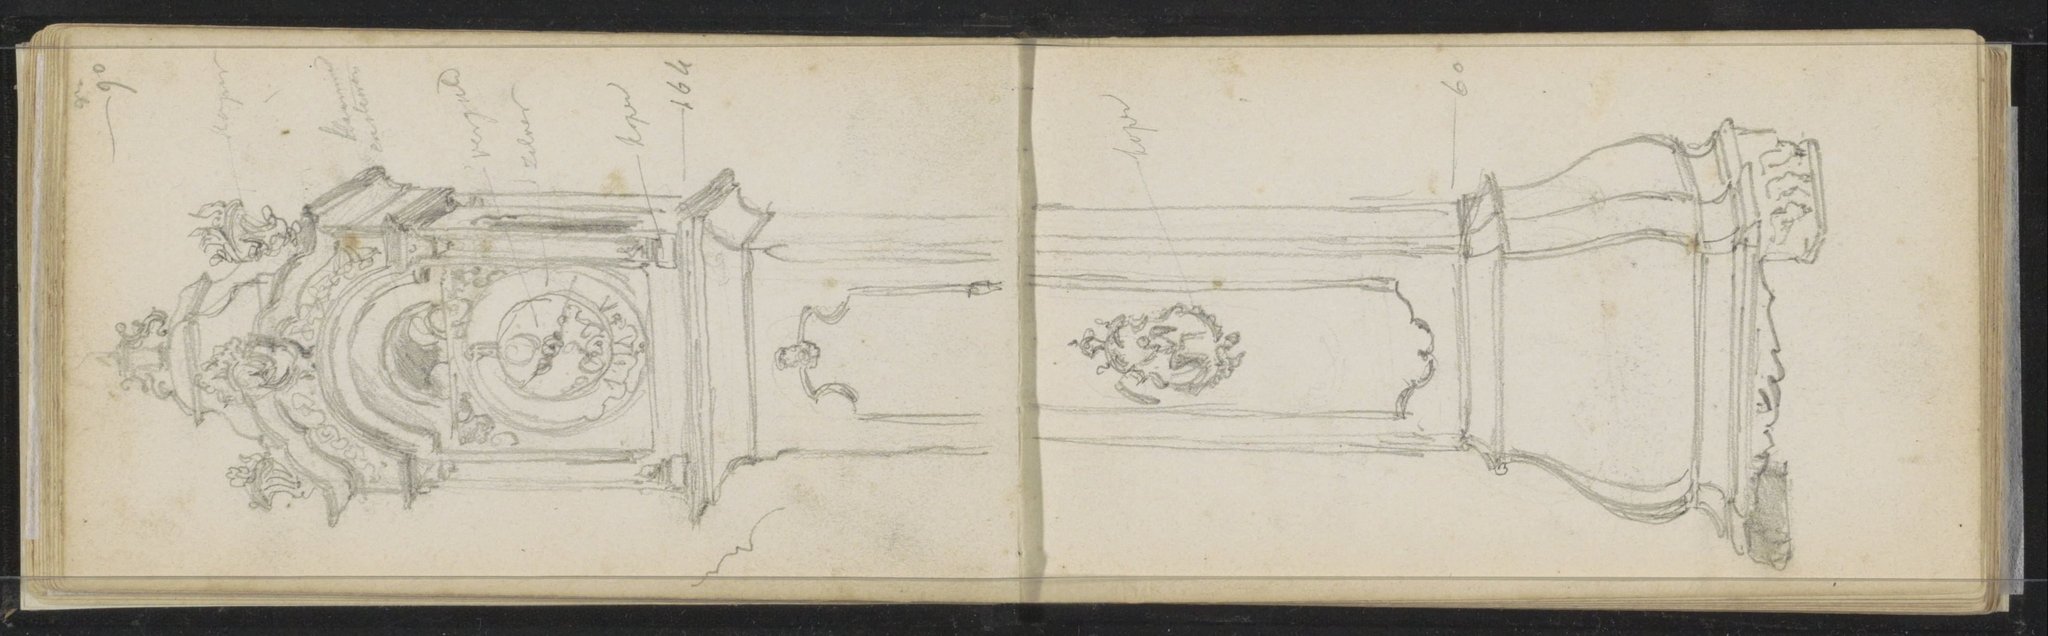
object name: sketchbook leaf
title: Staande klok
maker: cornelis springer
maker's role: draughtsman, painter, print maker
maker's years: 1817-1891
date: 1860-1866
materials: paper, pencil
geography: netherlands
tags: clock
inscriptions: annotation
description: Staande klok. Blad 13 verso en blad 14 recto uit een schetsboek met 44 bladen.